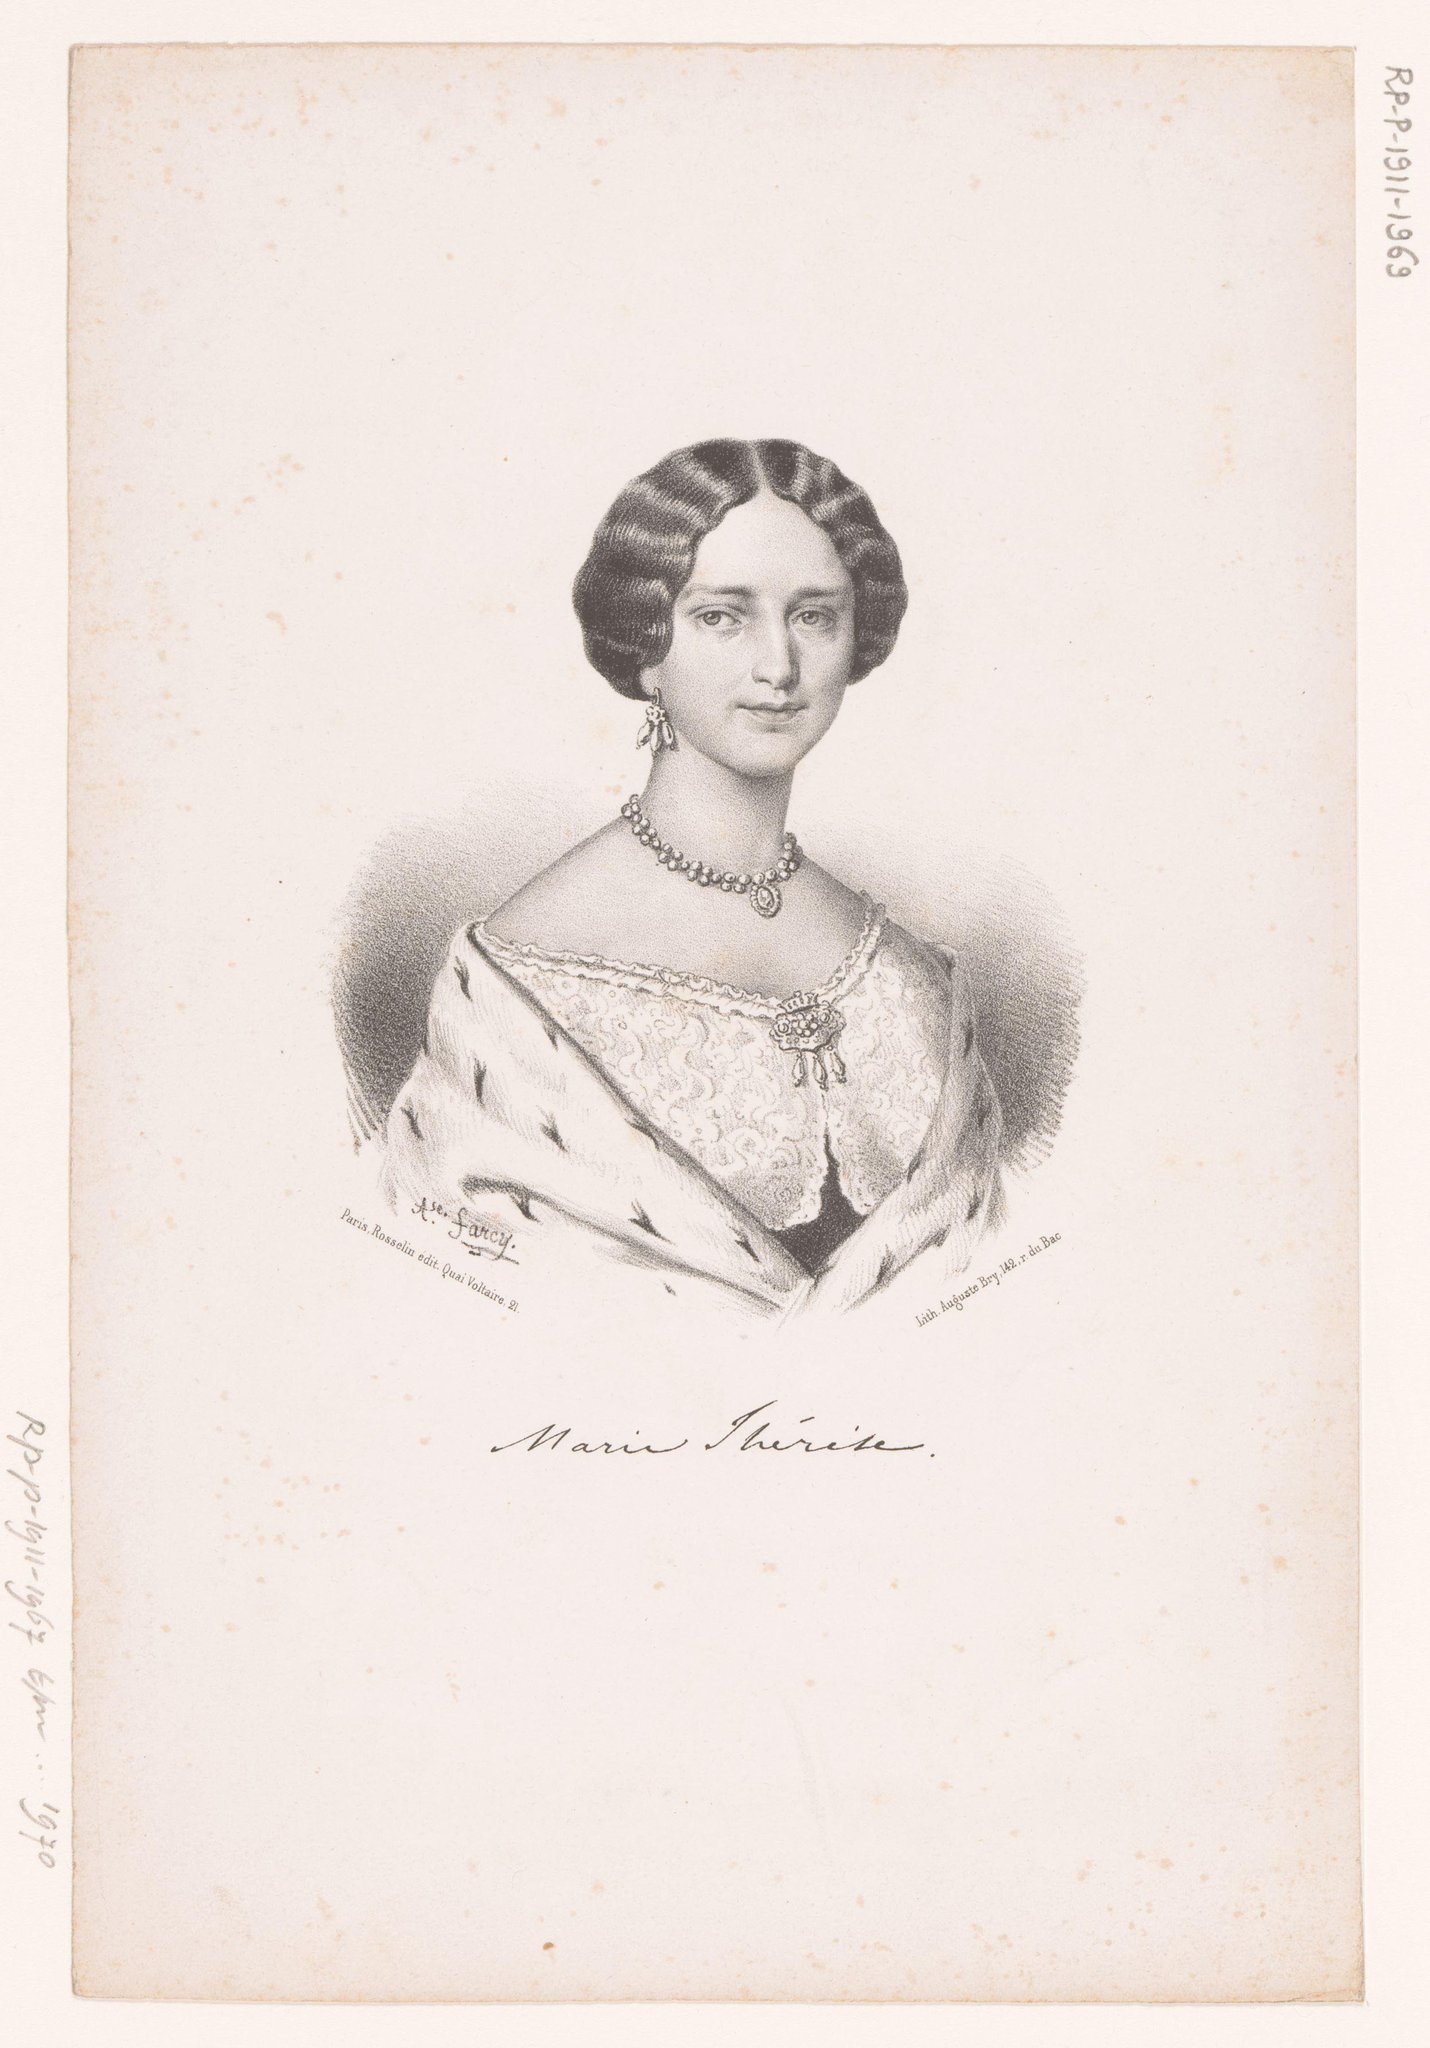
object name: print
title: Portret van Maria Theresia, prinses van Modena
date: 1849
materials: paper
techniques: lithograph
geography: paris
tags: historical persons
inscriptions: collector's mark: Lugt 2228a